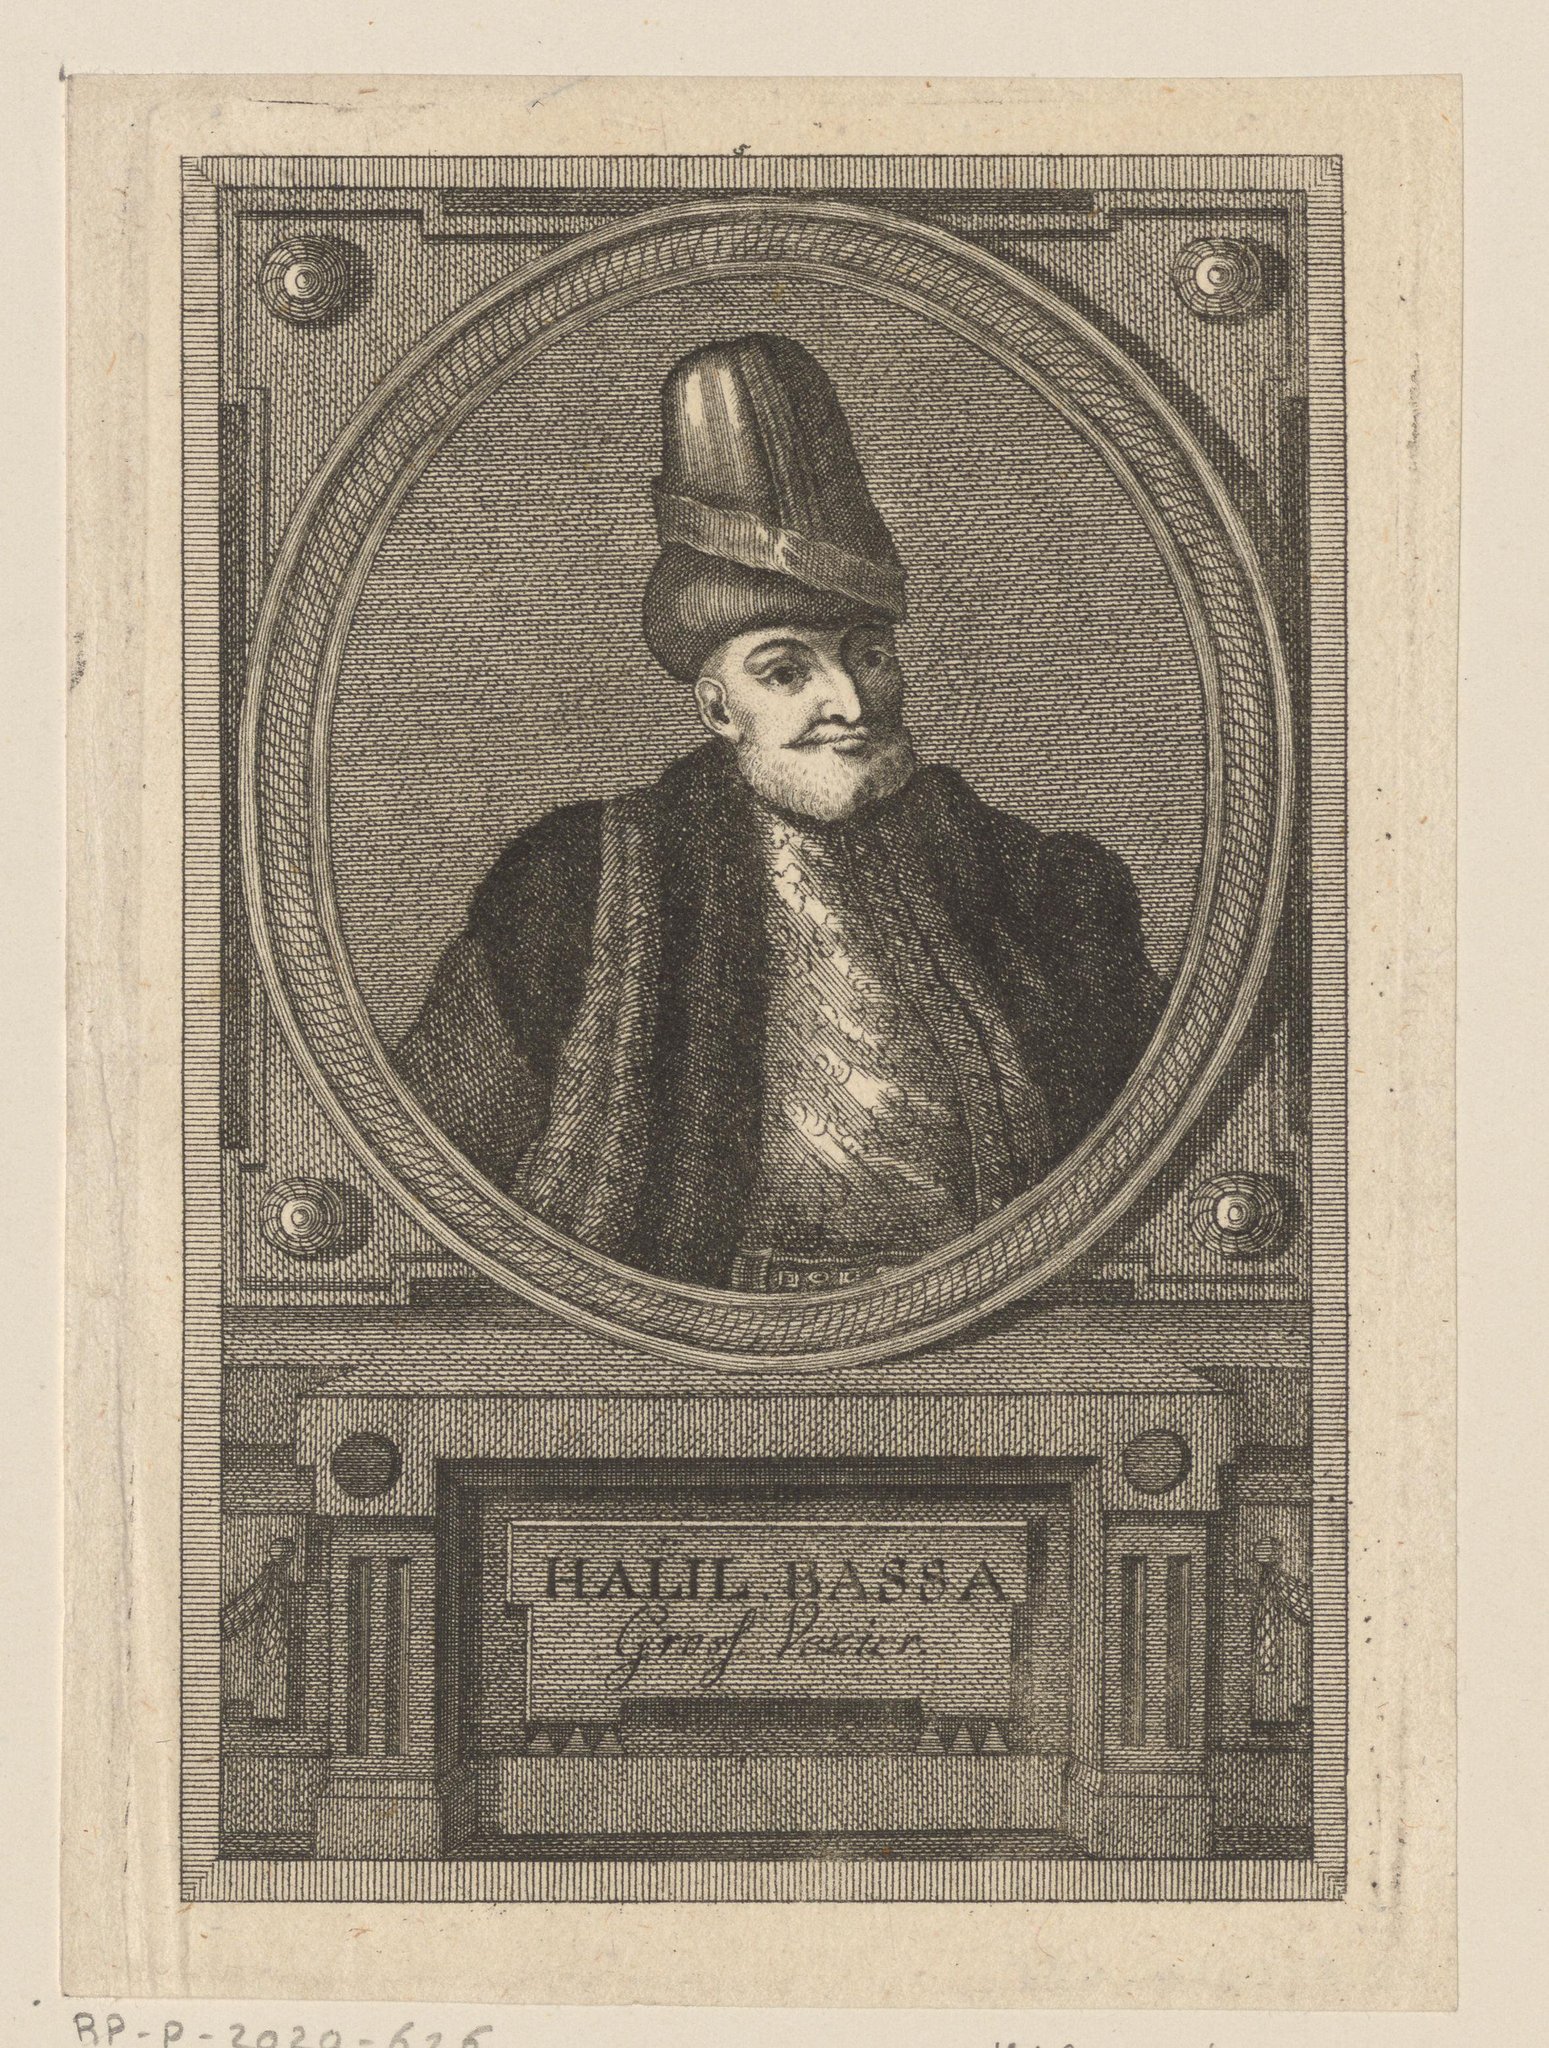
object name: print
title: Portret van waarschijnlijk Ivazzade Halil Pasja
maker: Anonymous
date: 1771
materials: paper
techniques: etching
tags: historical persons, head-gear: turban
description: Prent uit: Caminer, Domenico. Geschichte des gegenwärtigen Kriegs zwischen Russland, Polen und der Ottomannischen Pforte. Frankfurt en Leipzig: s.n., 1771, dl. 5.